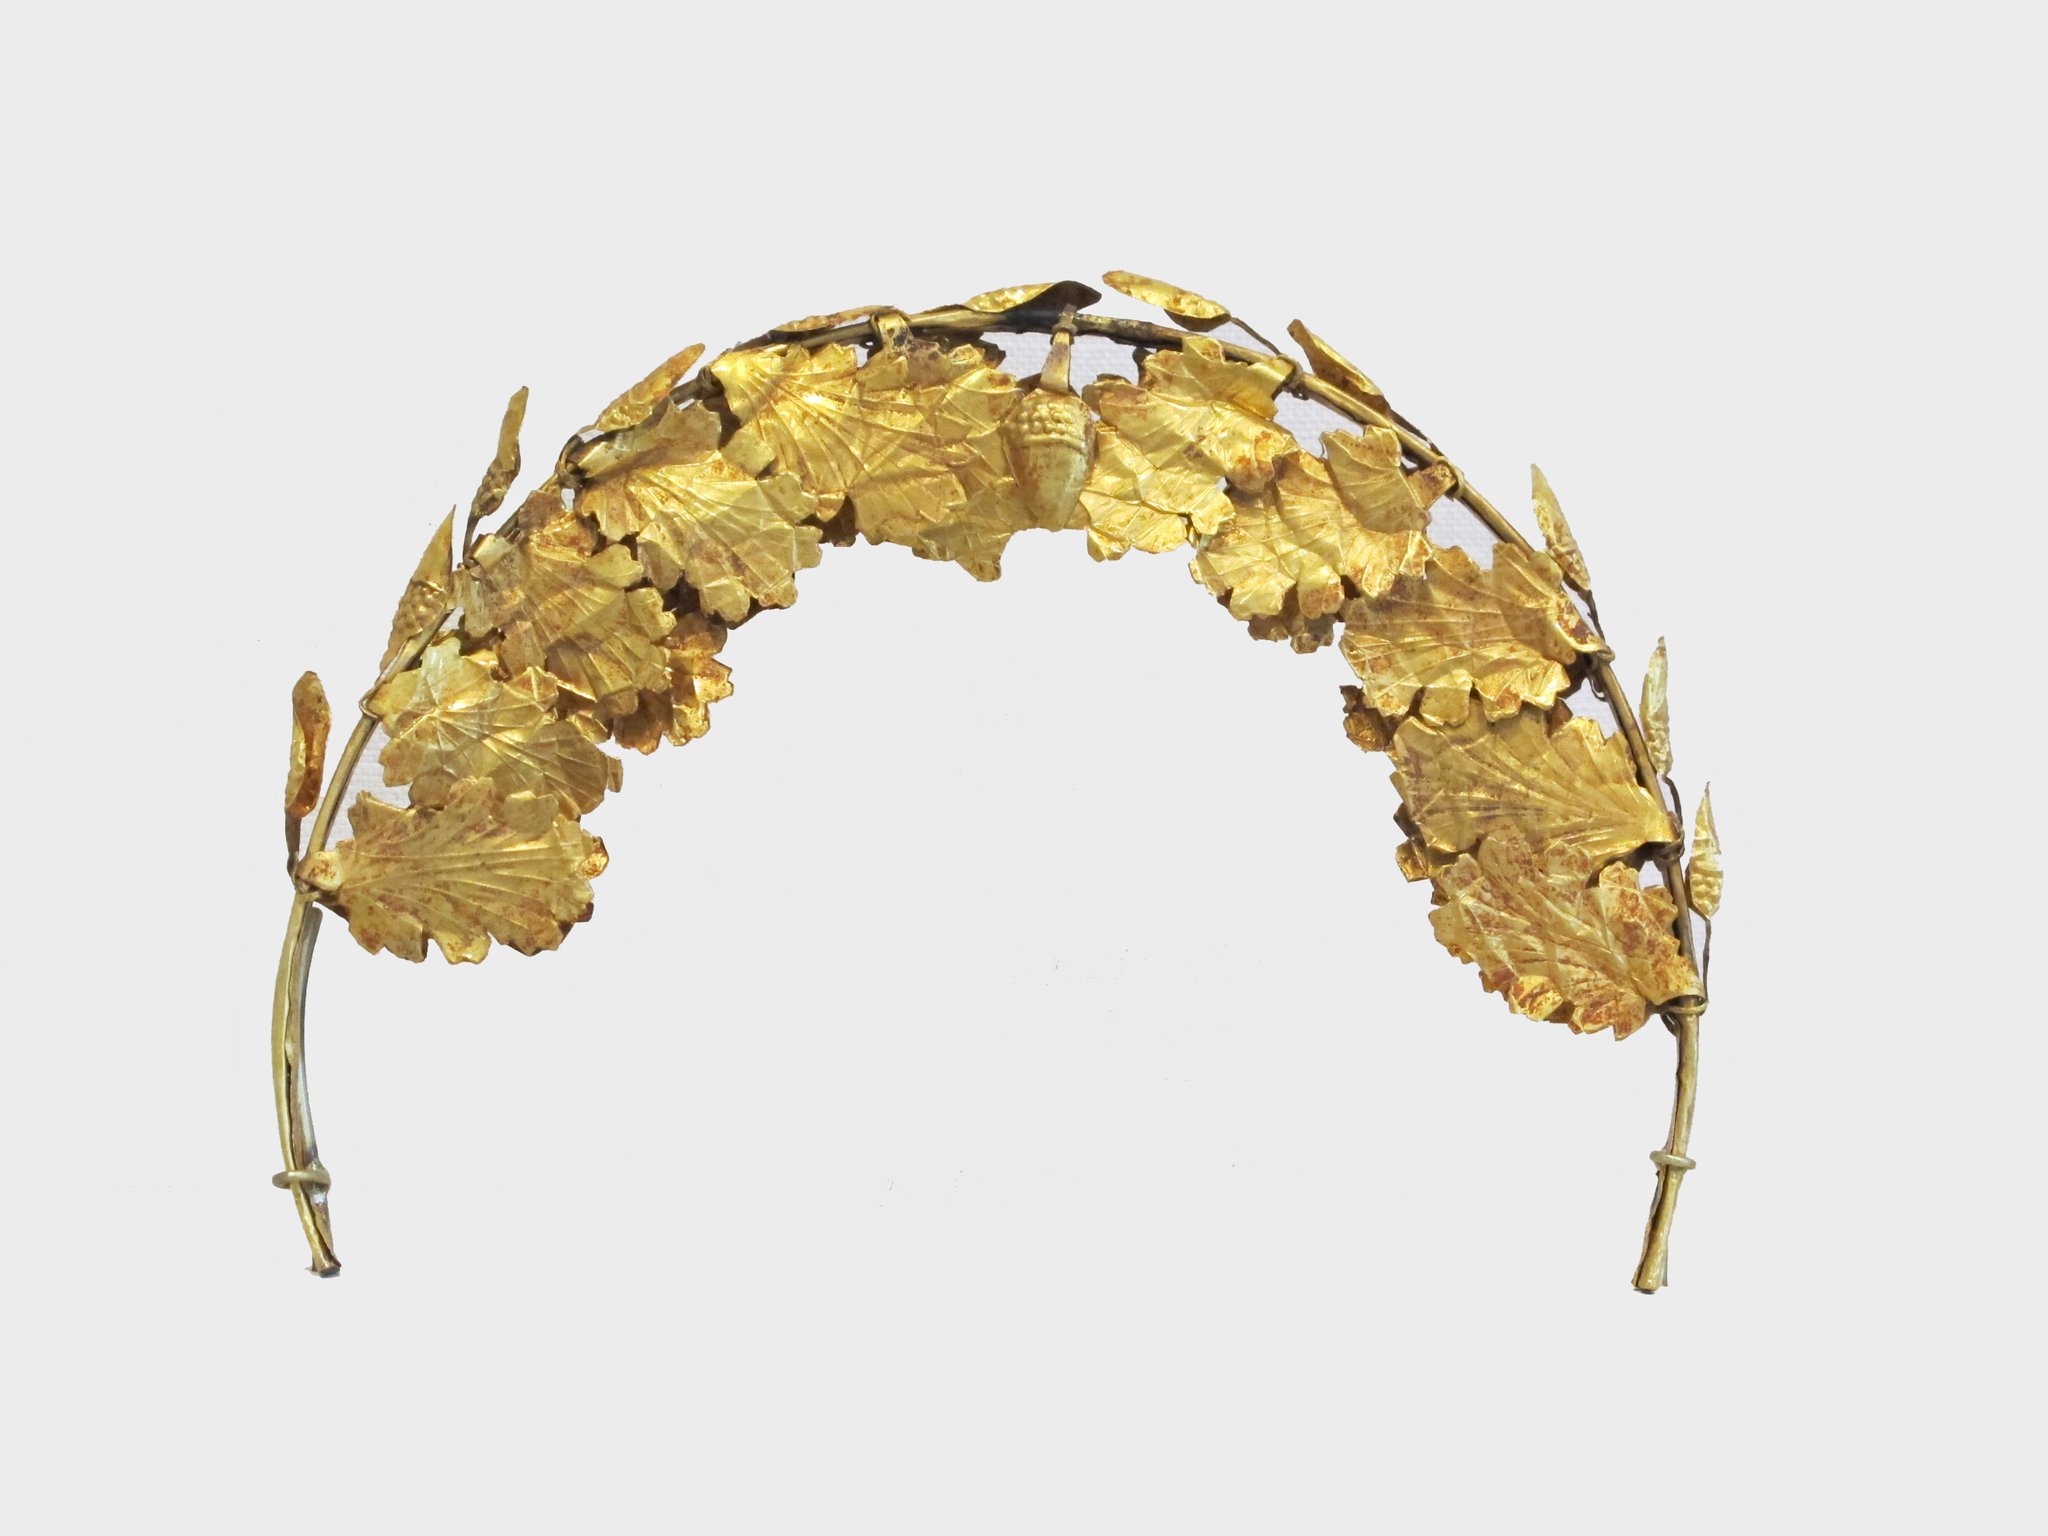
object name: wreath, funerary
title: Gold funerary wreath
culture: roman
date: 1-200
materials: gold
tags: wreaths